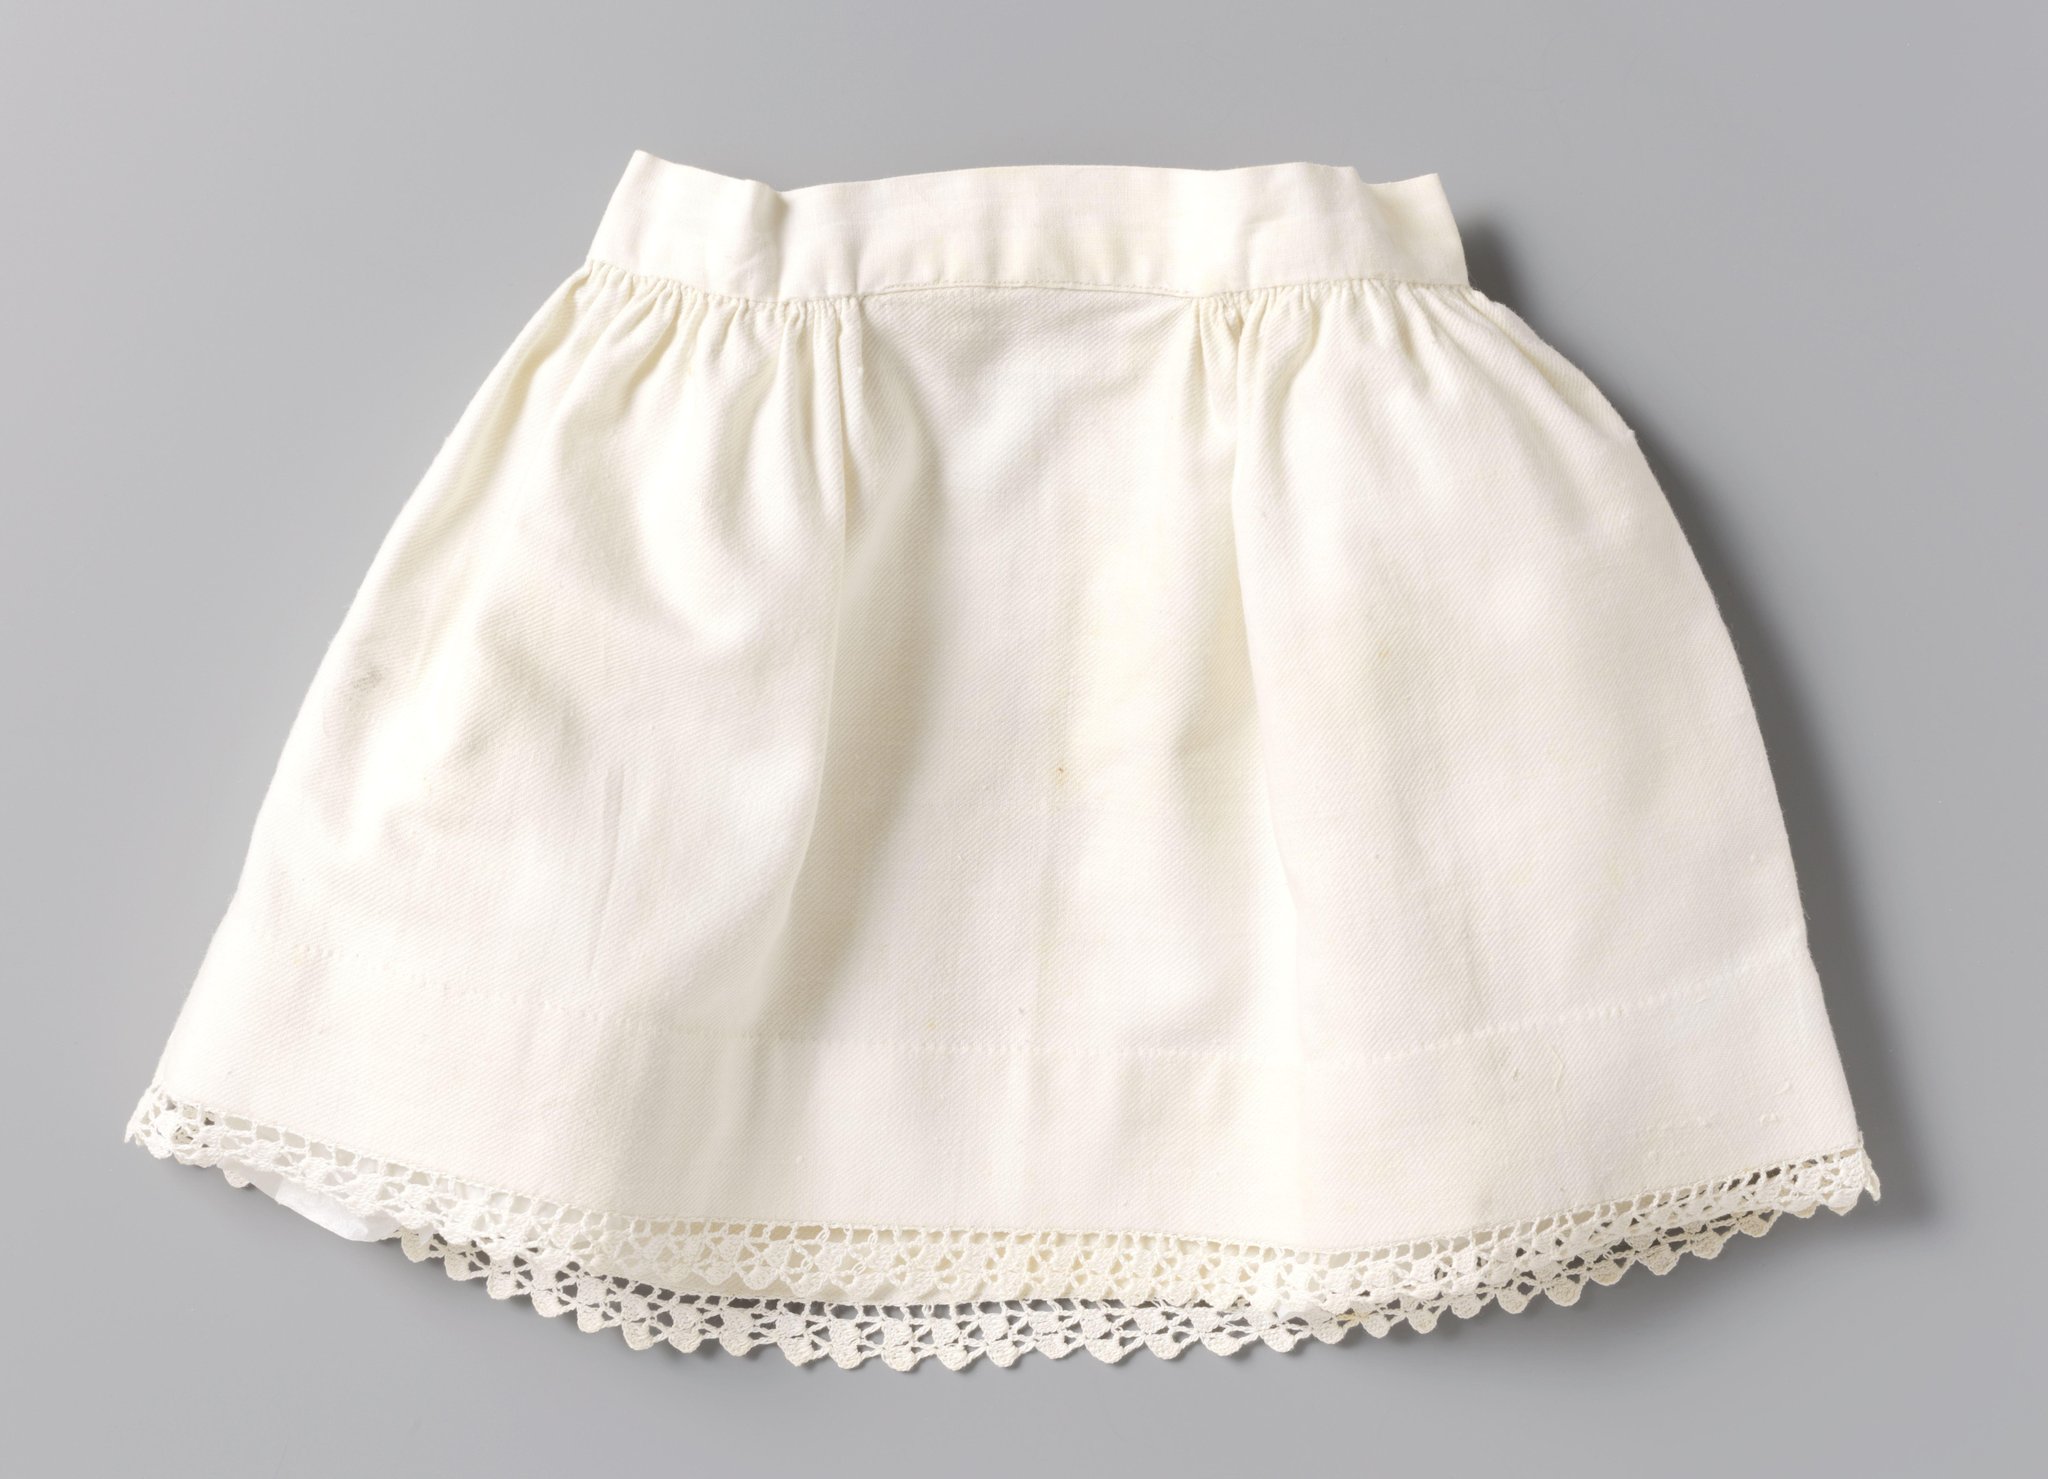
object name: underwear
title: Onderrok van katoenen keper met een rand van grof gehaakte schulpen.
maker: Anonymous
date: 1918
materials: cotton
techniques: crochet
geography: amsterdam